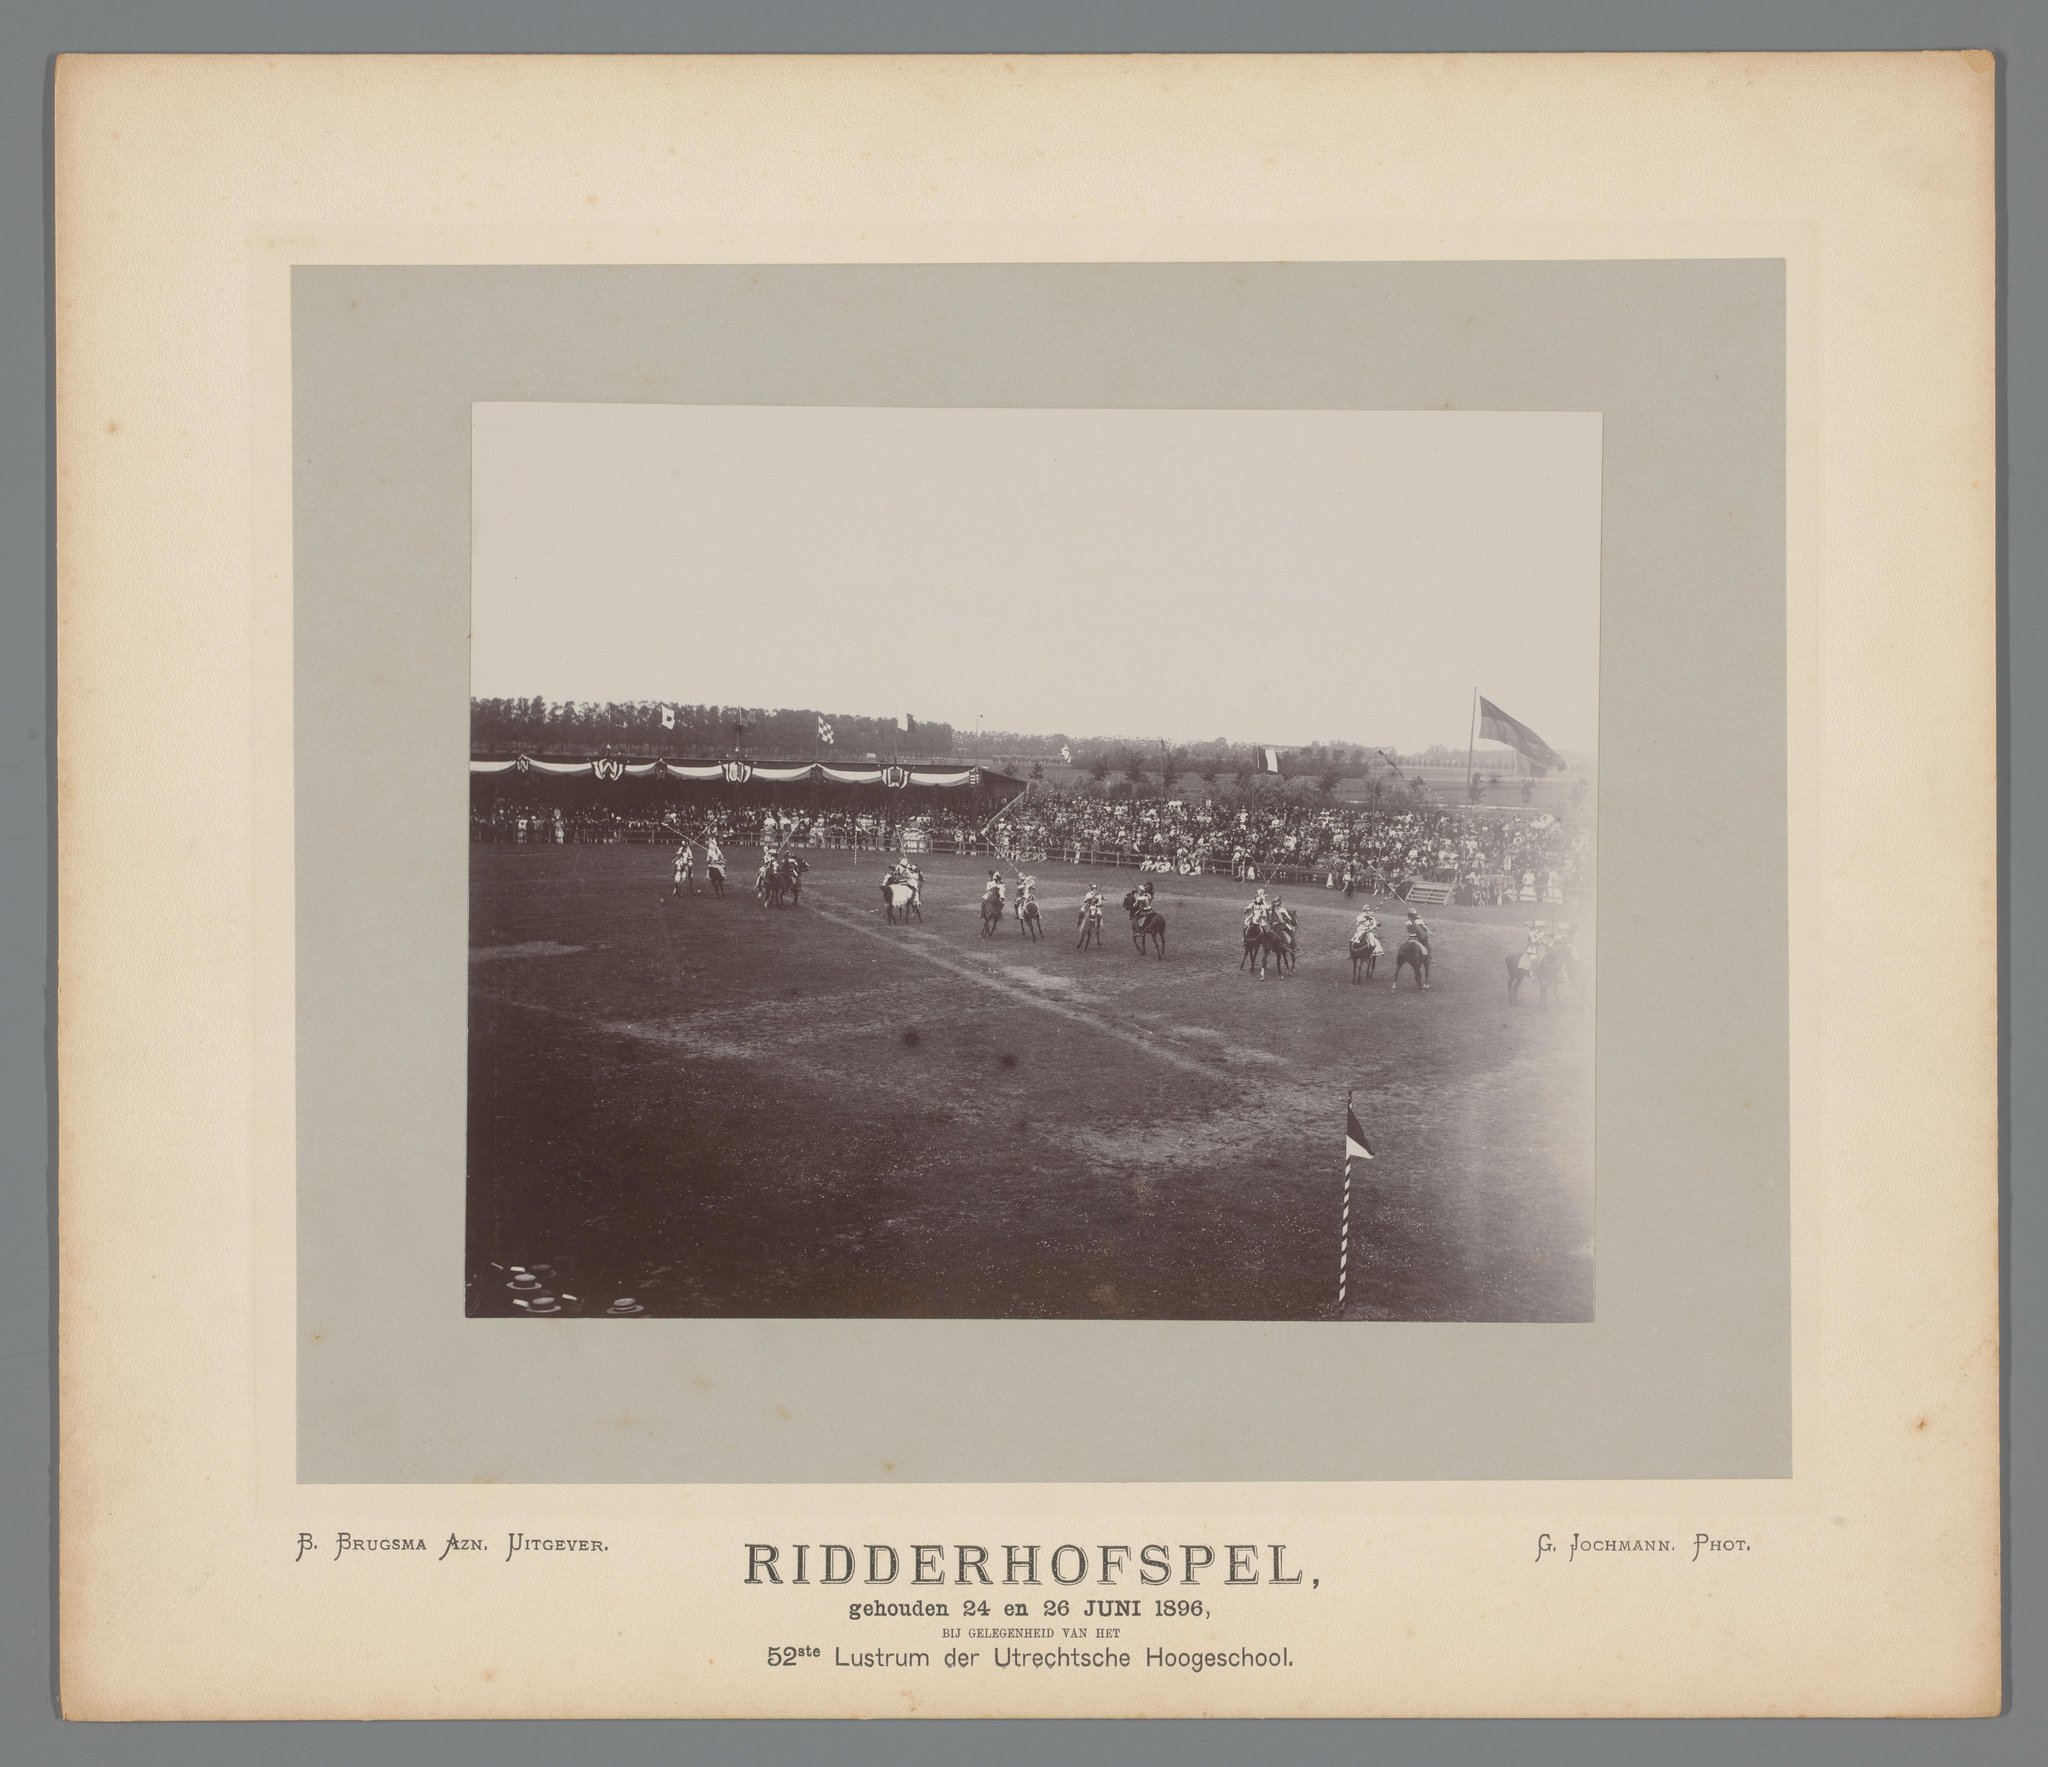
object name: photograph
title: Ridders in duel tijdens de Ridderhofspelen op 24 en 26 juni 1896 in Utrecht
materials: cardboard, paper, photographic support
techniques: collodion silver print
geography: utrecht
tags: (medieval) fighting contest, public festivities, duelling, utrecht